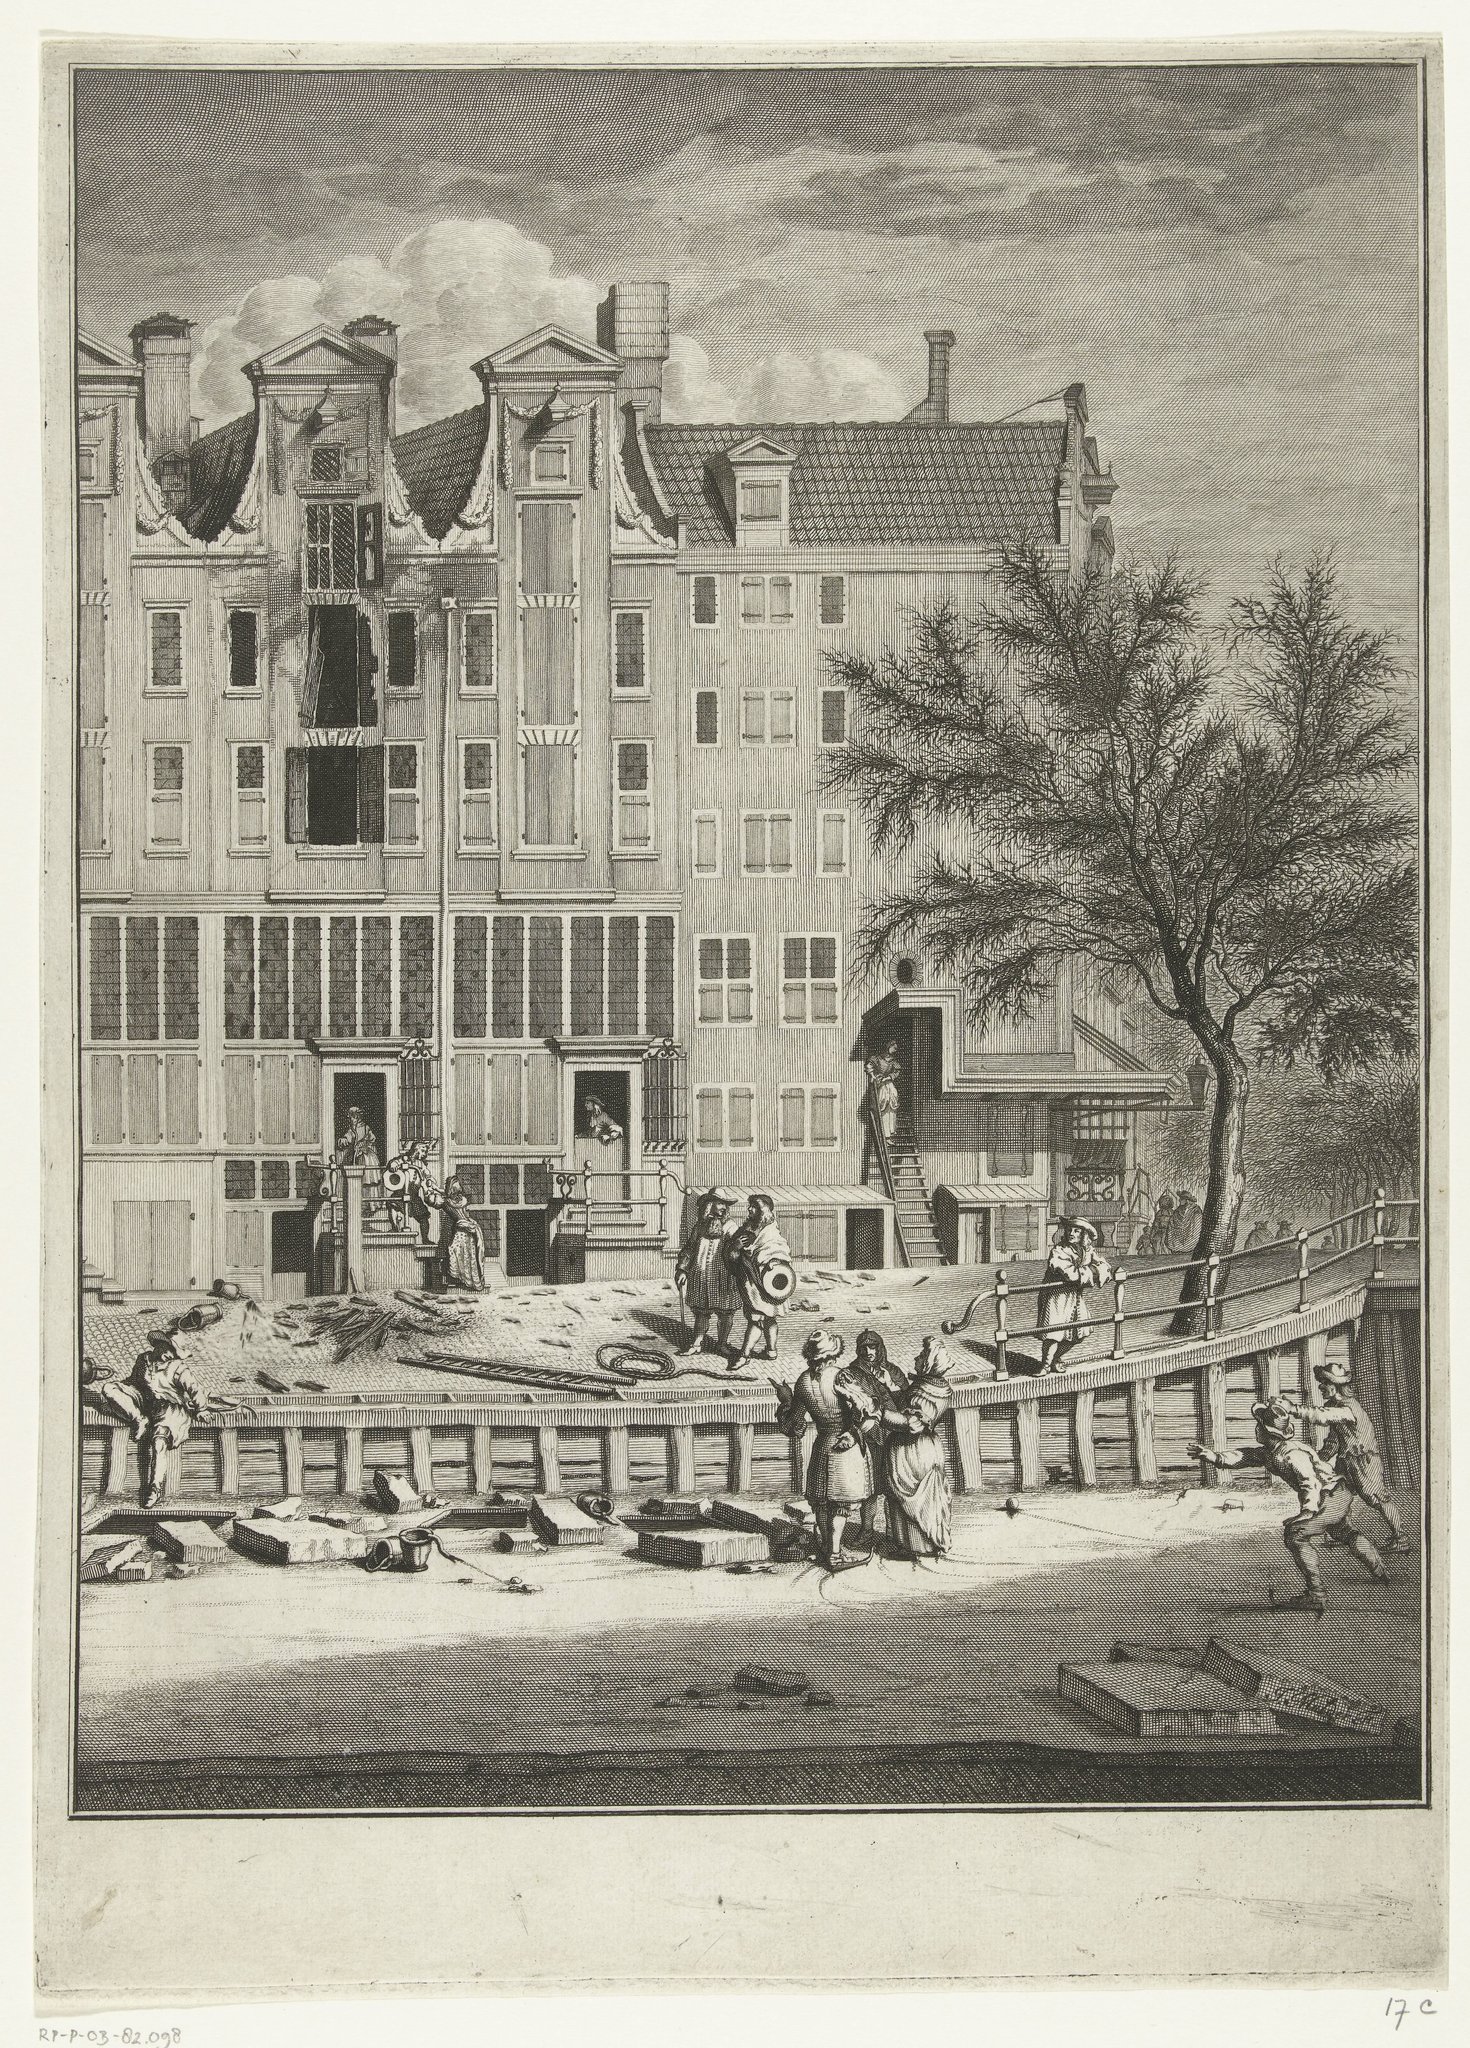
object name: print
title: Uitgebrand huis op de Leidsegracht, 1684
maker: joseph mulder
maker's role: print maker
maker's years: 1658-1718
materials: paper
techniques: engraving, etching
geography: amsterdam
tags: amsterdam, painter, print maker, jan van der heyden, urban housing, ruin of a building ~ architecture, skates (winter sports), canals, waters (in city), fire-fighting, fire-extinguishing equipment, severe winters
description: Latere staat van prent ook gebruikt in: Heyden, Jan van der. Beschryving der nieuwlyks uitgevonden en geoctrojeerde slang-brand-spuiten en haare wyze van brand-blussen, tegenwoordig binnen Amsterdam in gebruik zijnde (…). 1e druk. Amsterdam: Jan Rieuwertsz. (II), 1690. En in: Heyden, Jan van der. Beschryving der nieuwlyks uitgevonden en geoctrojeerde slang-brand-spuiten en haare wyze van brand-blussen, tegenwoordig binnen Amsterdam in gebruik zijnde (…). 2e druk. Amsterdam: erfgenamen Jan van der Heyden, 1735. Voor ontwerptekeningen zie RP-T-1899-A-4210 en RP-T-00-159. Voor eerste bekende staat zie RP-P-OB-2365. Voor derde bekende staat zie RP-P-AO-28-76-14, RP-P-OB-77.747 en RP-P-OB-102.829. Voor tegendruk van derde bekende staat zie RP-P-OB-82.097.